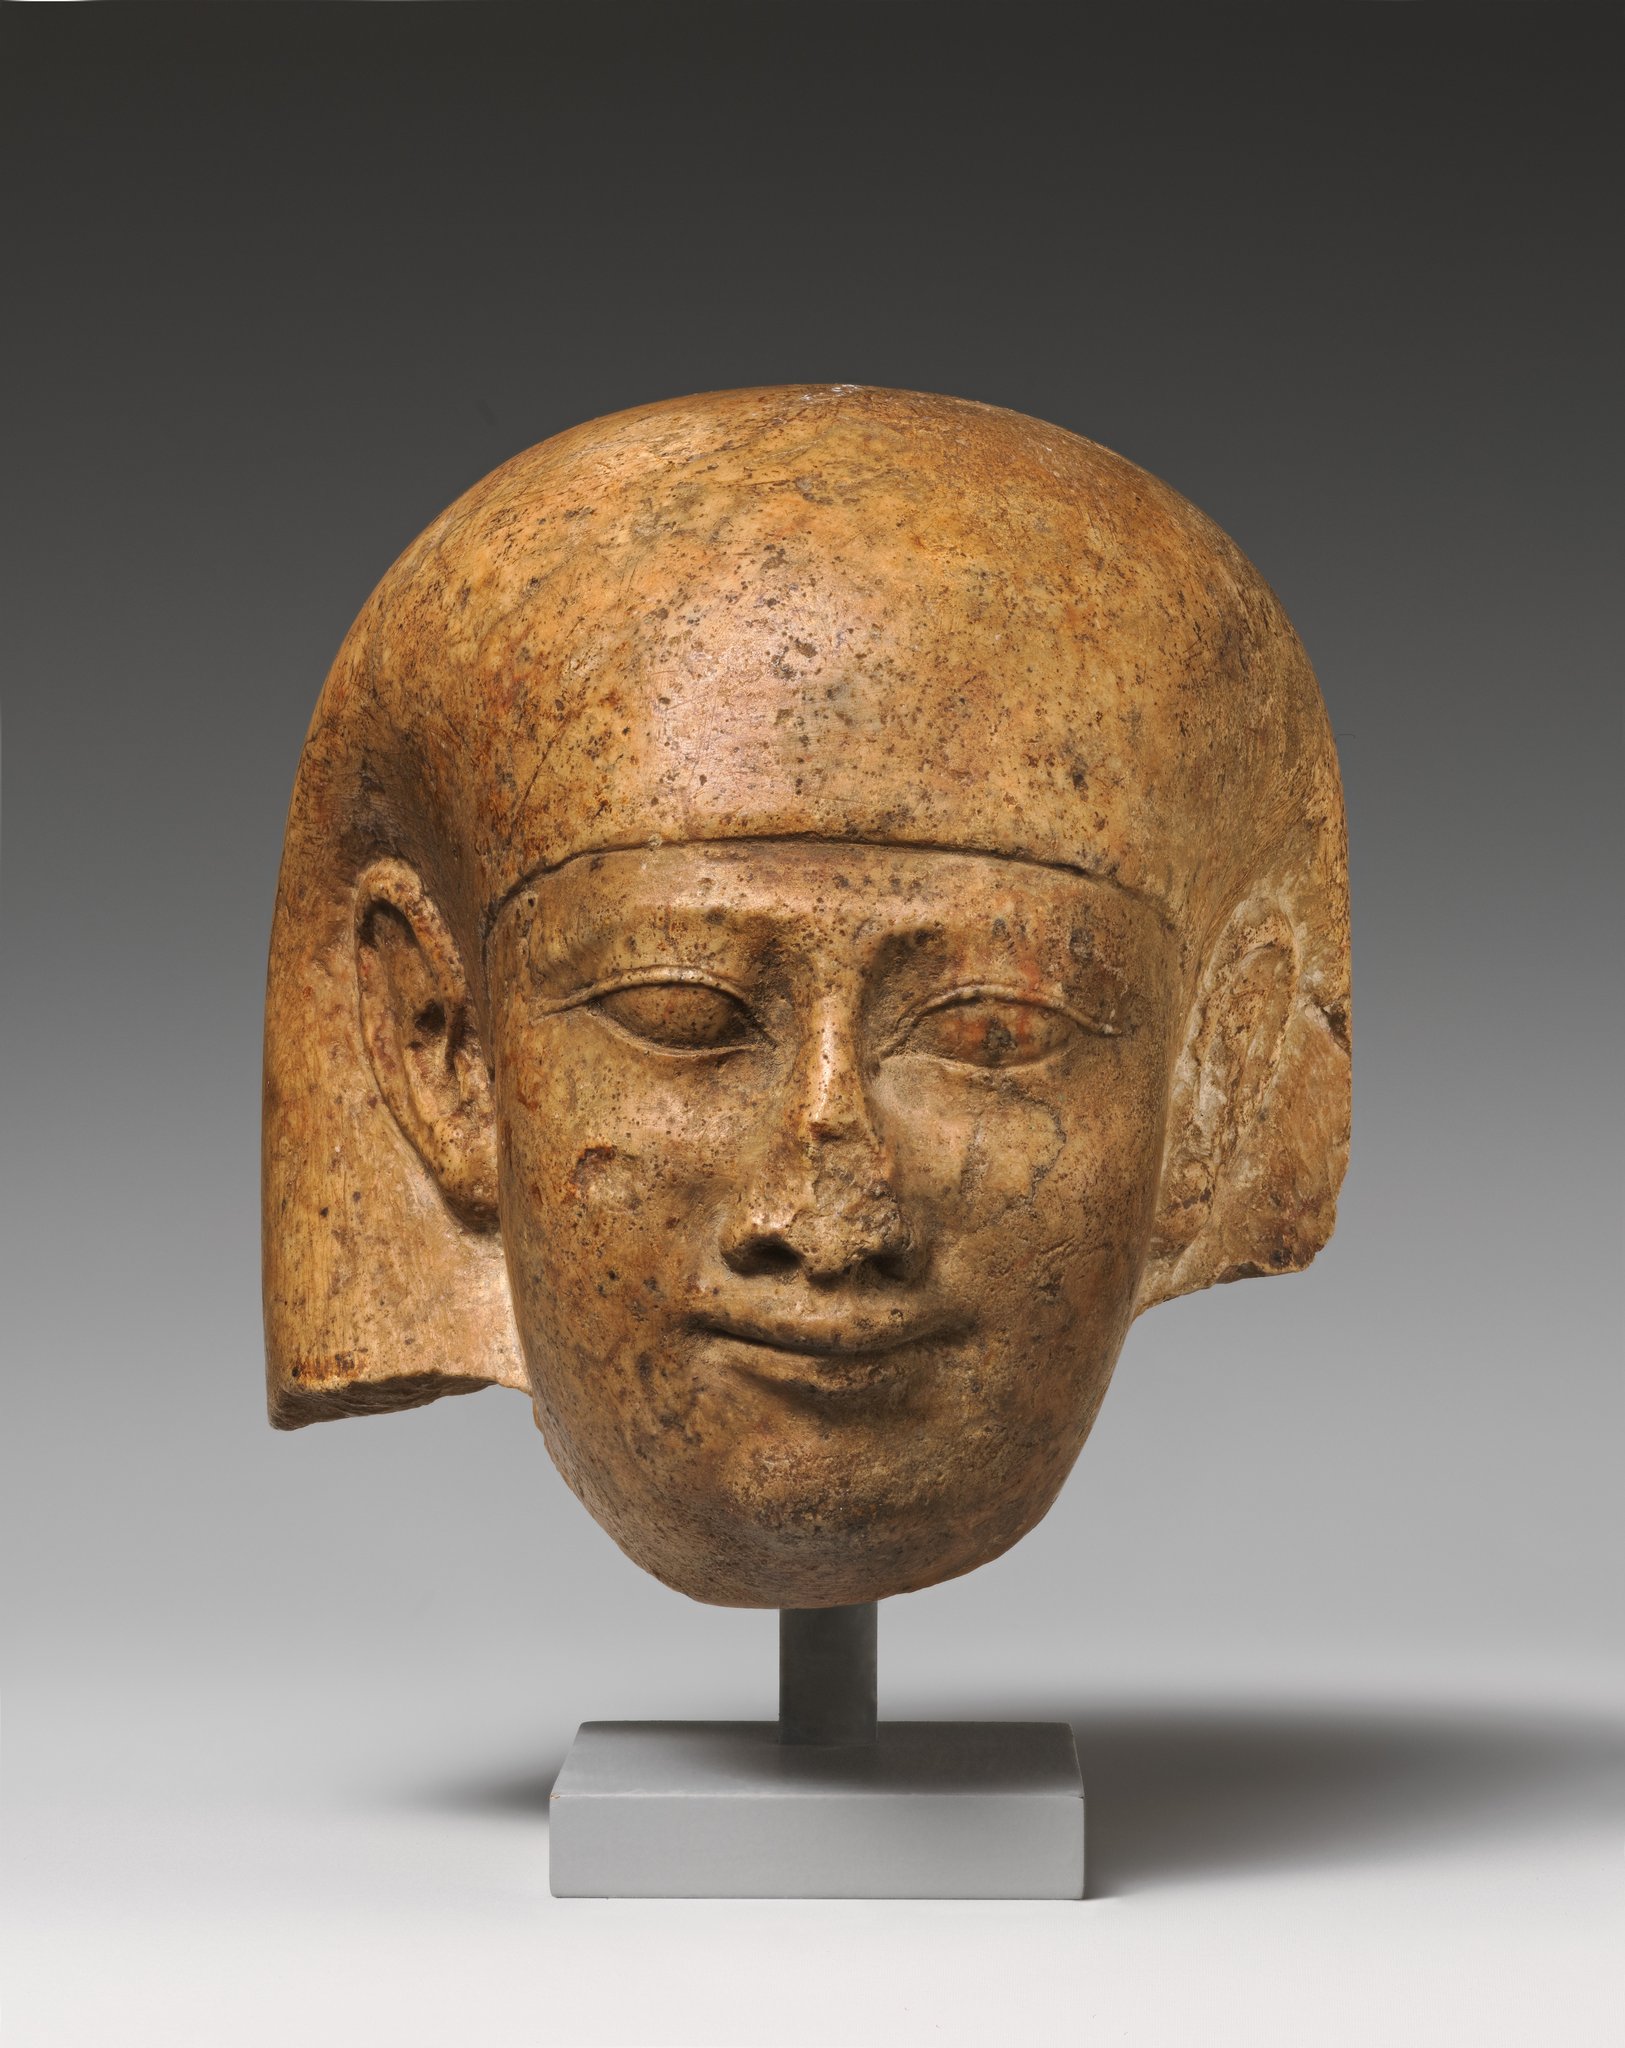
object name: head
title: Head of an official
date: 400-200 BCE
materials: quartzite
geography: egypt